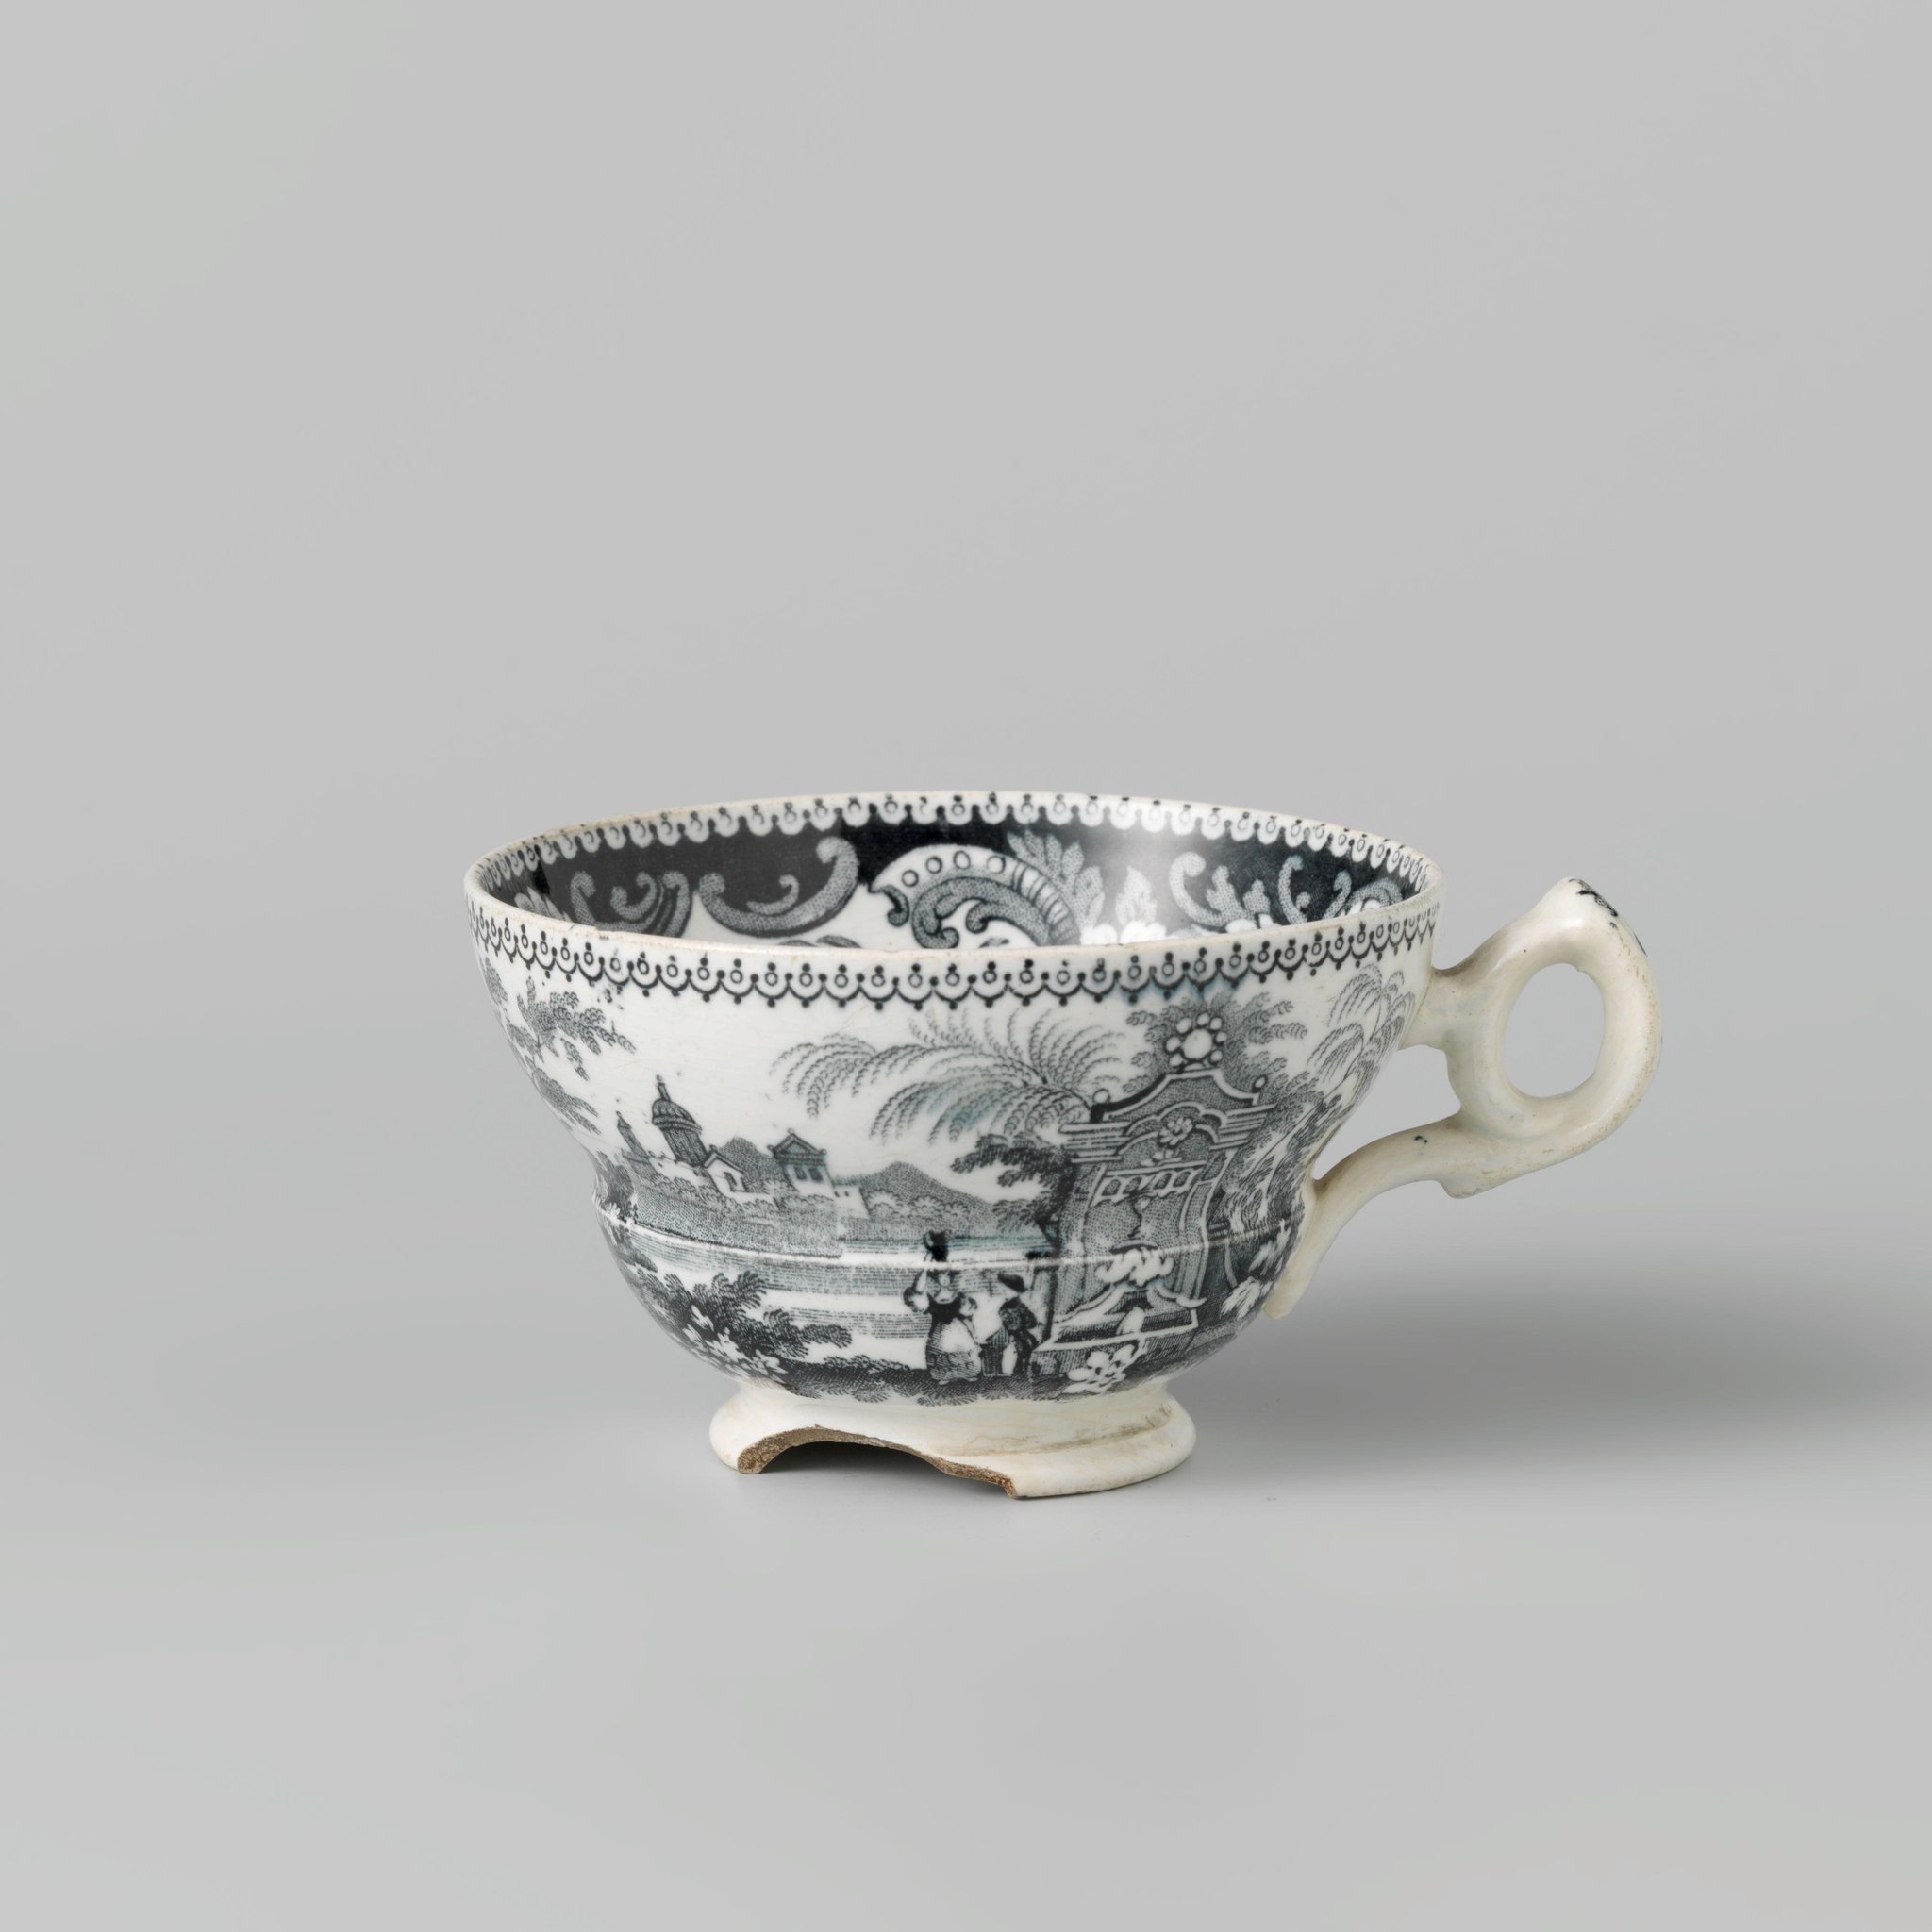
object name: cup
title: Kop van hardgebakken aardewerk; Stockton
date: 1850-1870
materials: earthenware, glaze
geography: stockton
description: Half bolvormige kop op een voet, met een insnoering in het midden van de wand en een C-vormig oor waarbinnen een gesloten cirkel. De kop is van wit aardewerk versierd met een zwarte overdruk. De buitenwand heeft een patroon van romantisch landschap, de binnenwand heeft een patroon van voluten en bloemen en in het midden een landschap. De kop hoort bij een servies waarvan enige stukken gemerkt zijn met "Wedgewood".